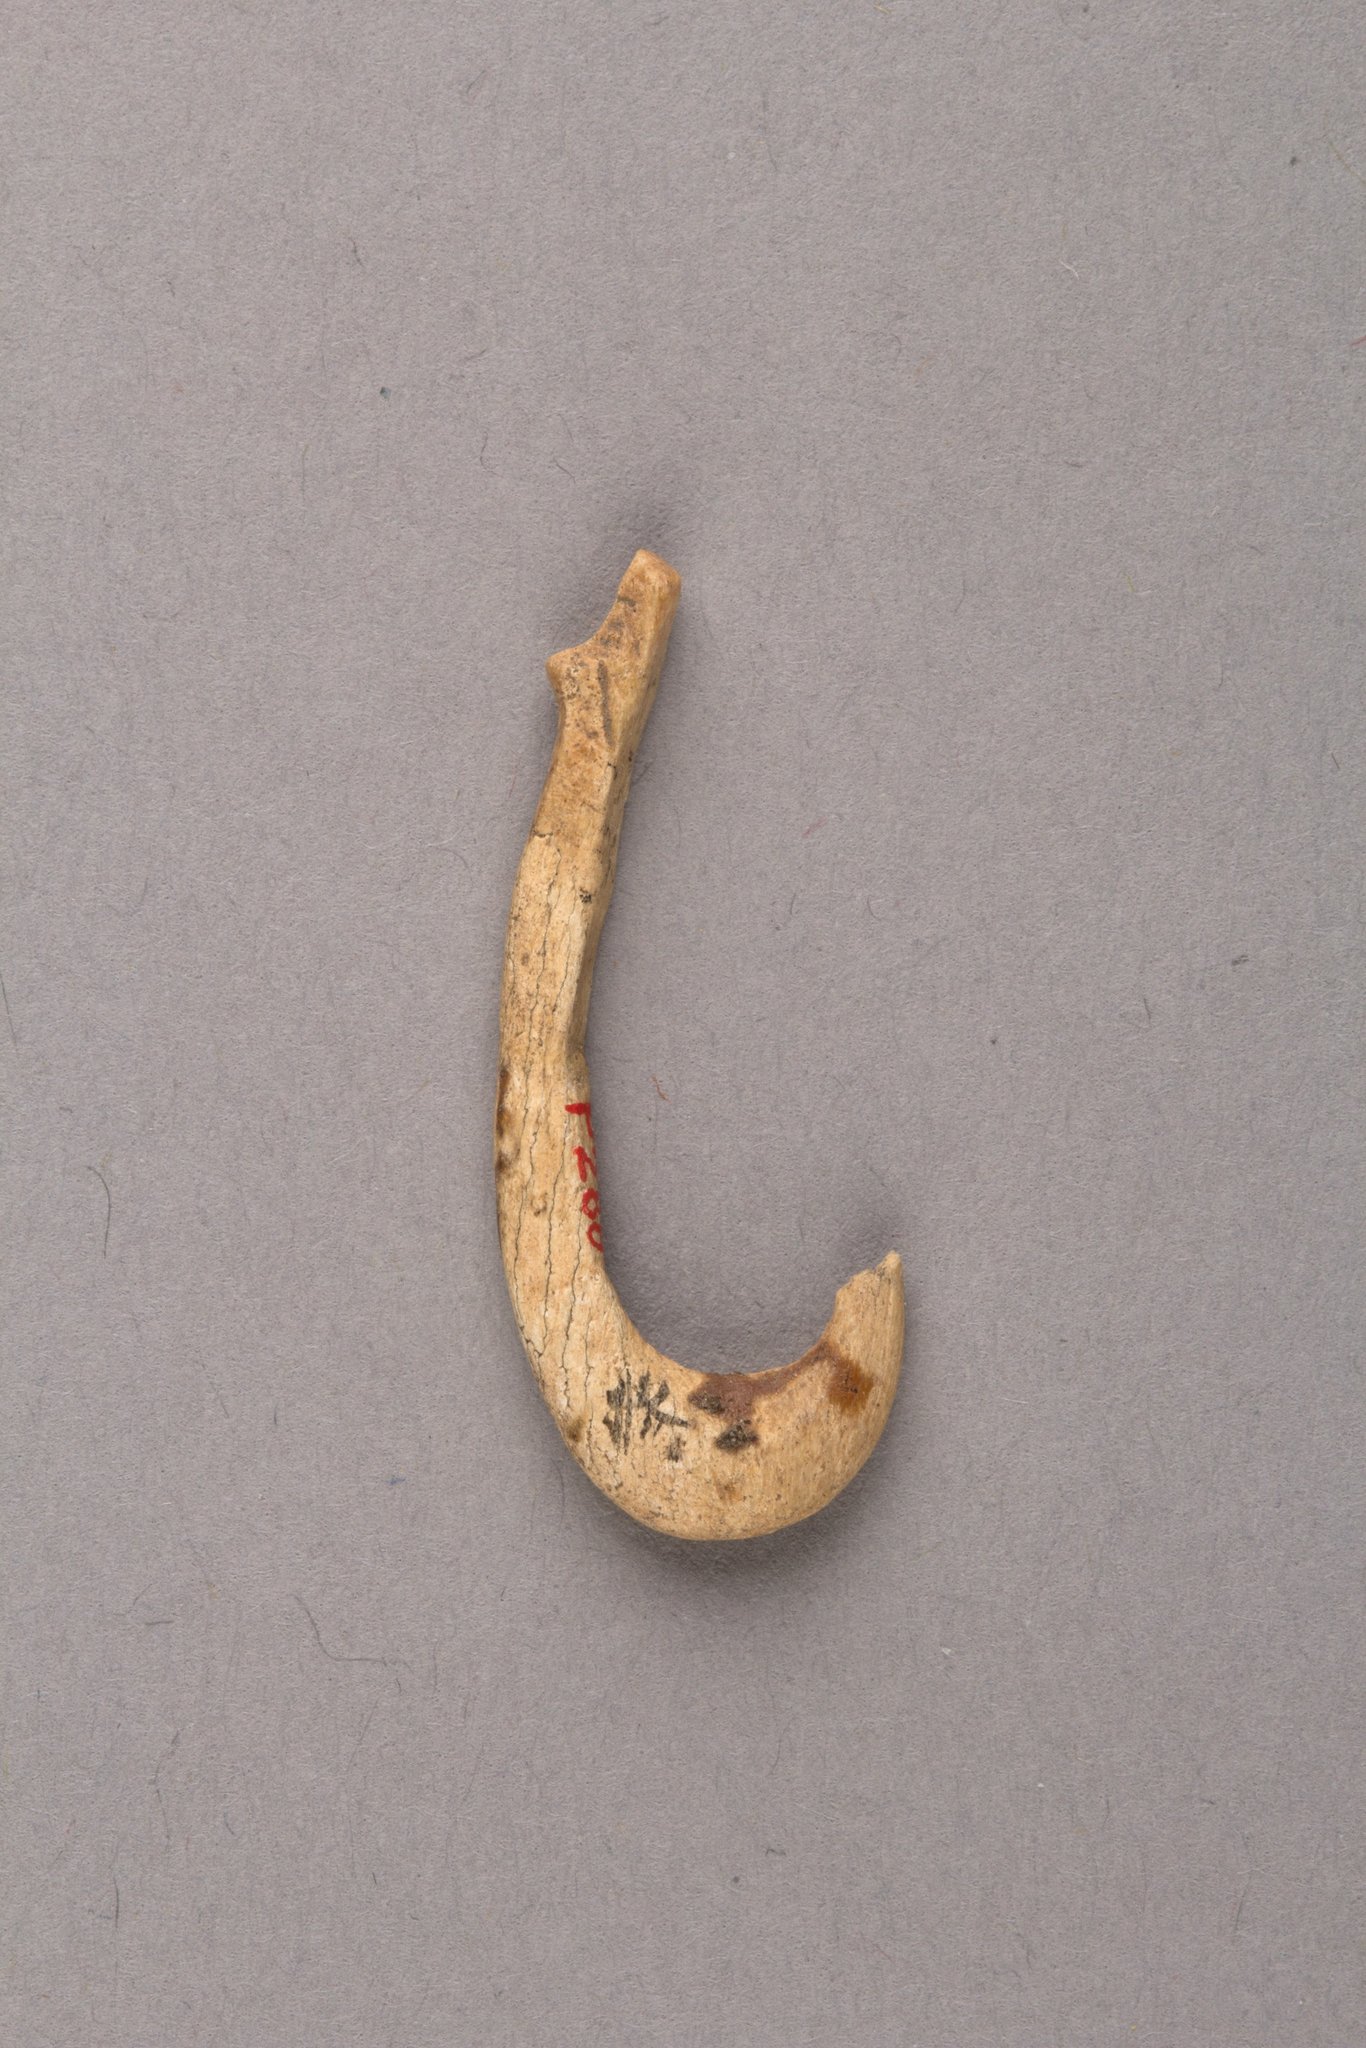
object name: fish hook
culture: japanese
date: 1000-300 BCE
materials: bone